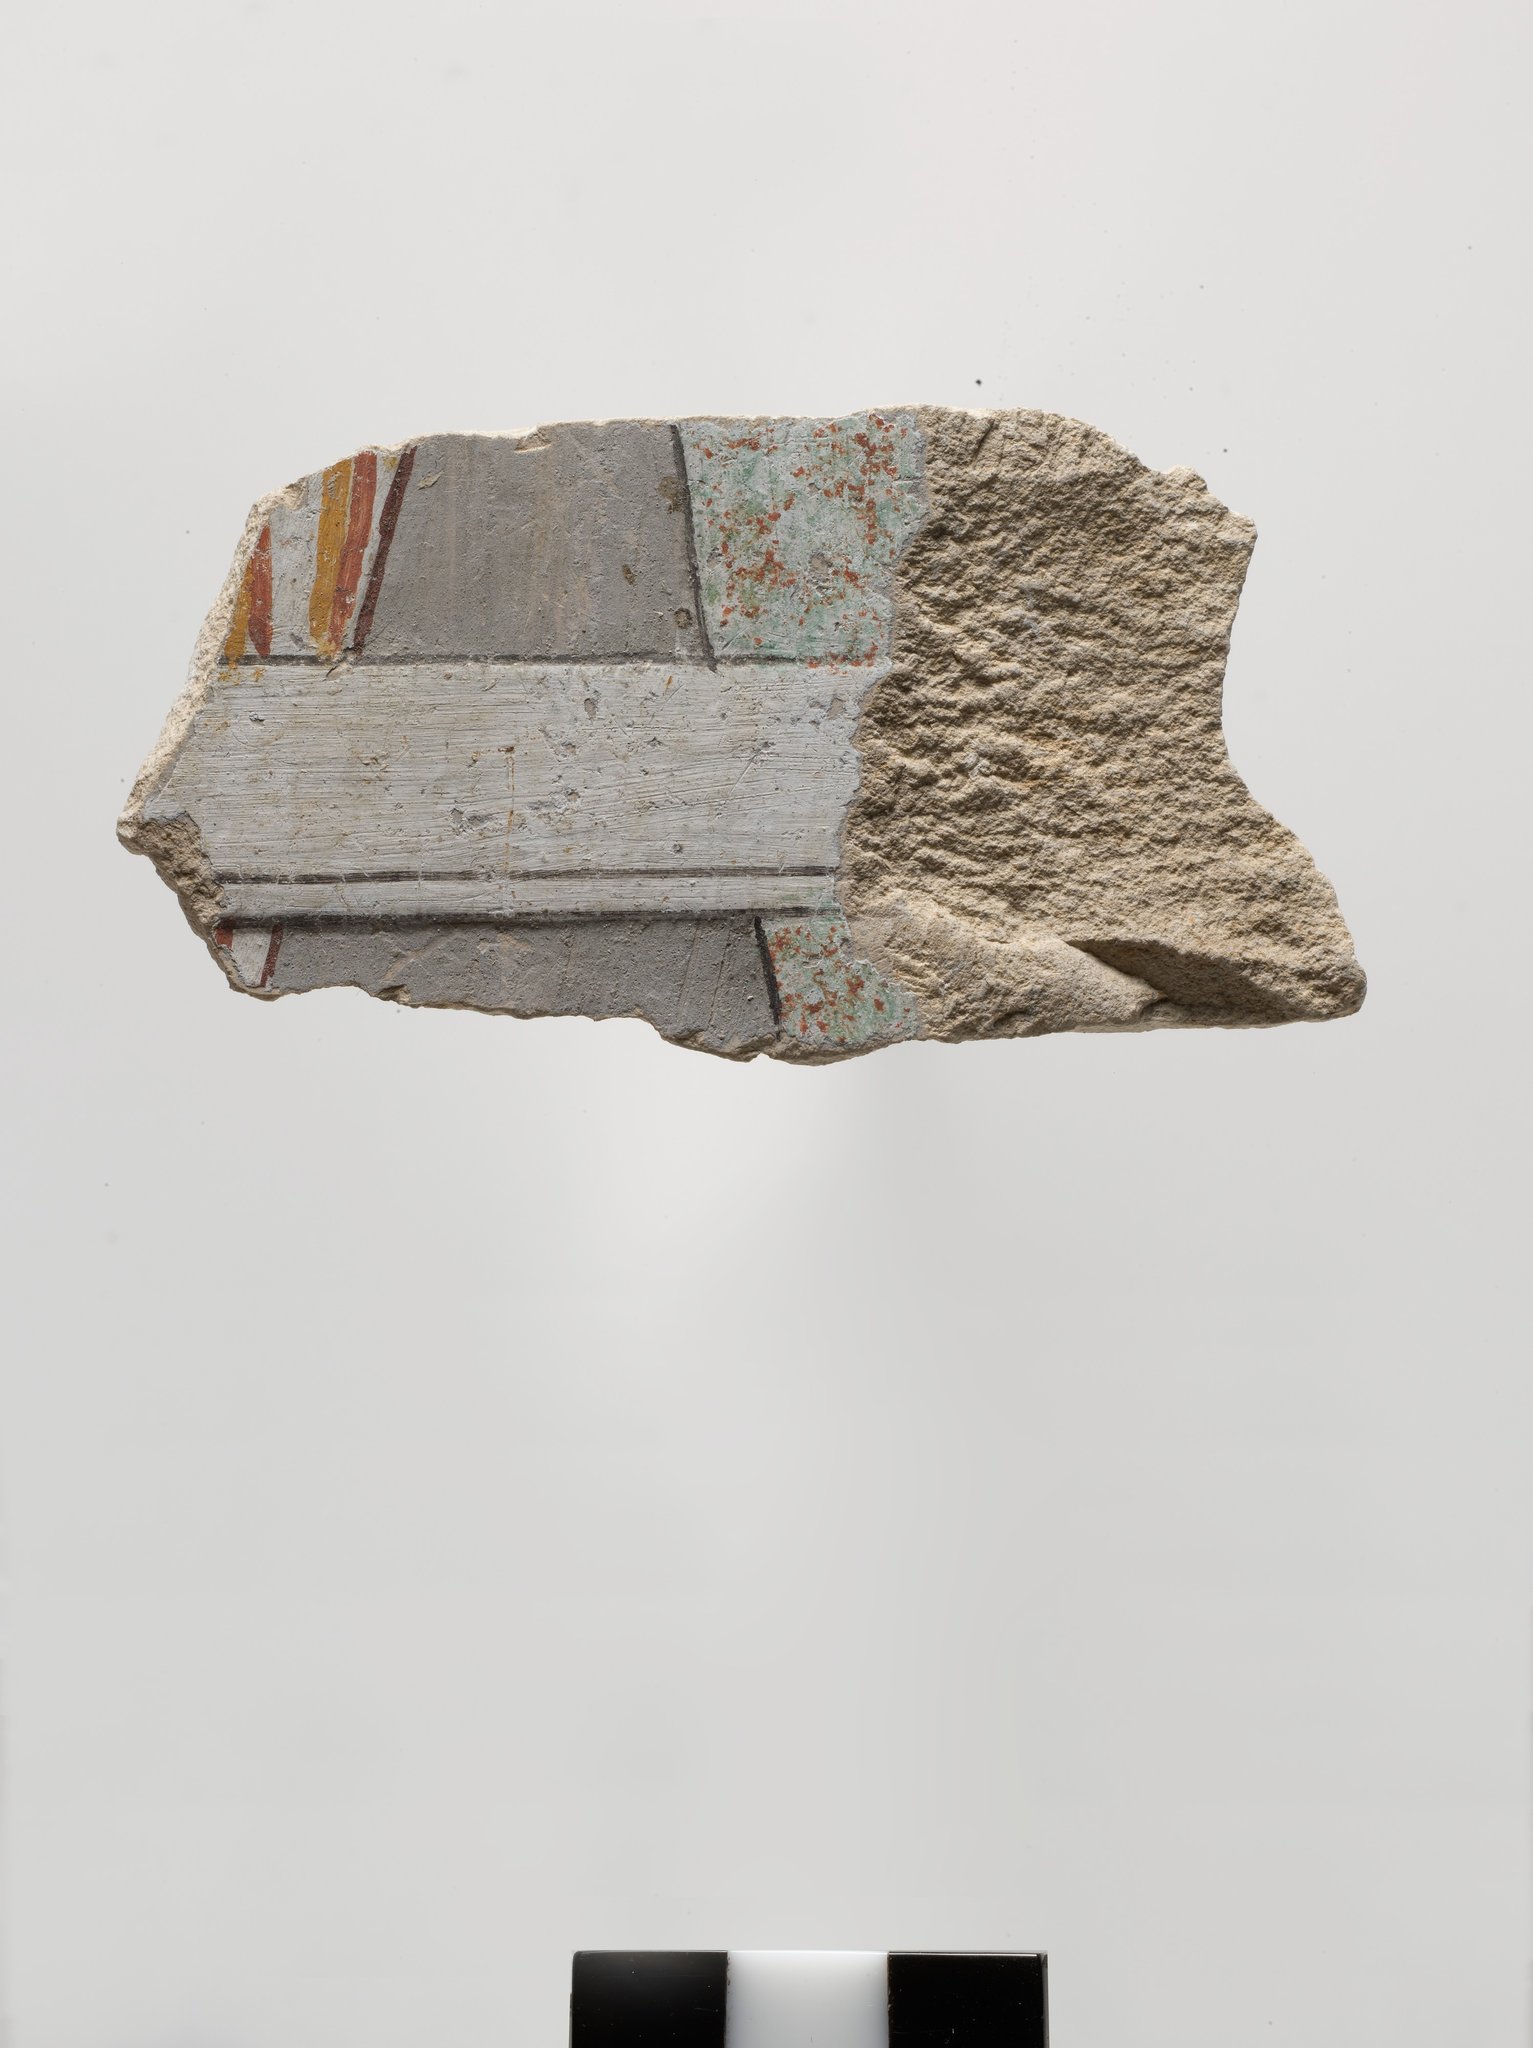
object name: relief fragment, tomb of meketre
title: Relief fragments from tomb of Meketre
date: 1981-1975 BCE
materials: limestone, paint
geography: egypt